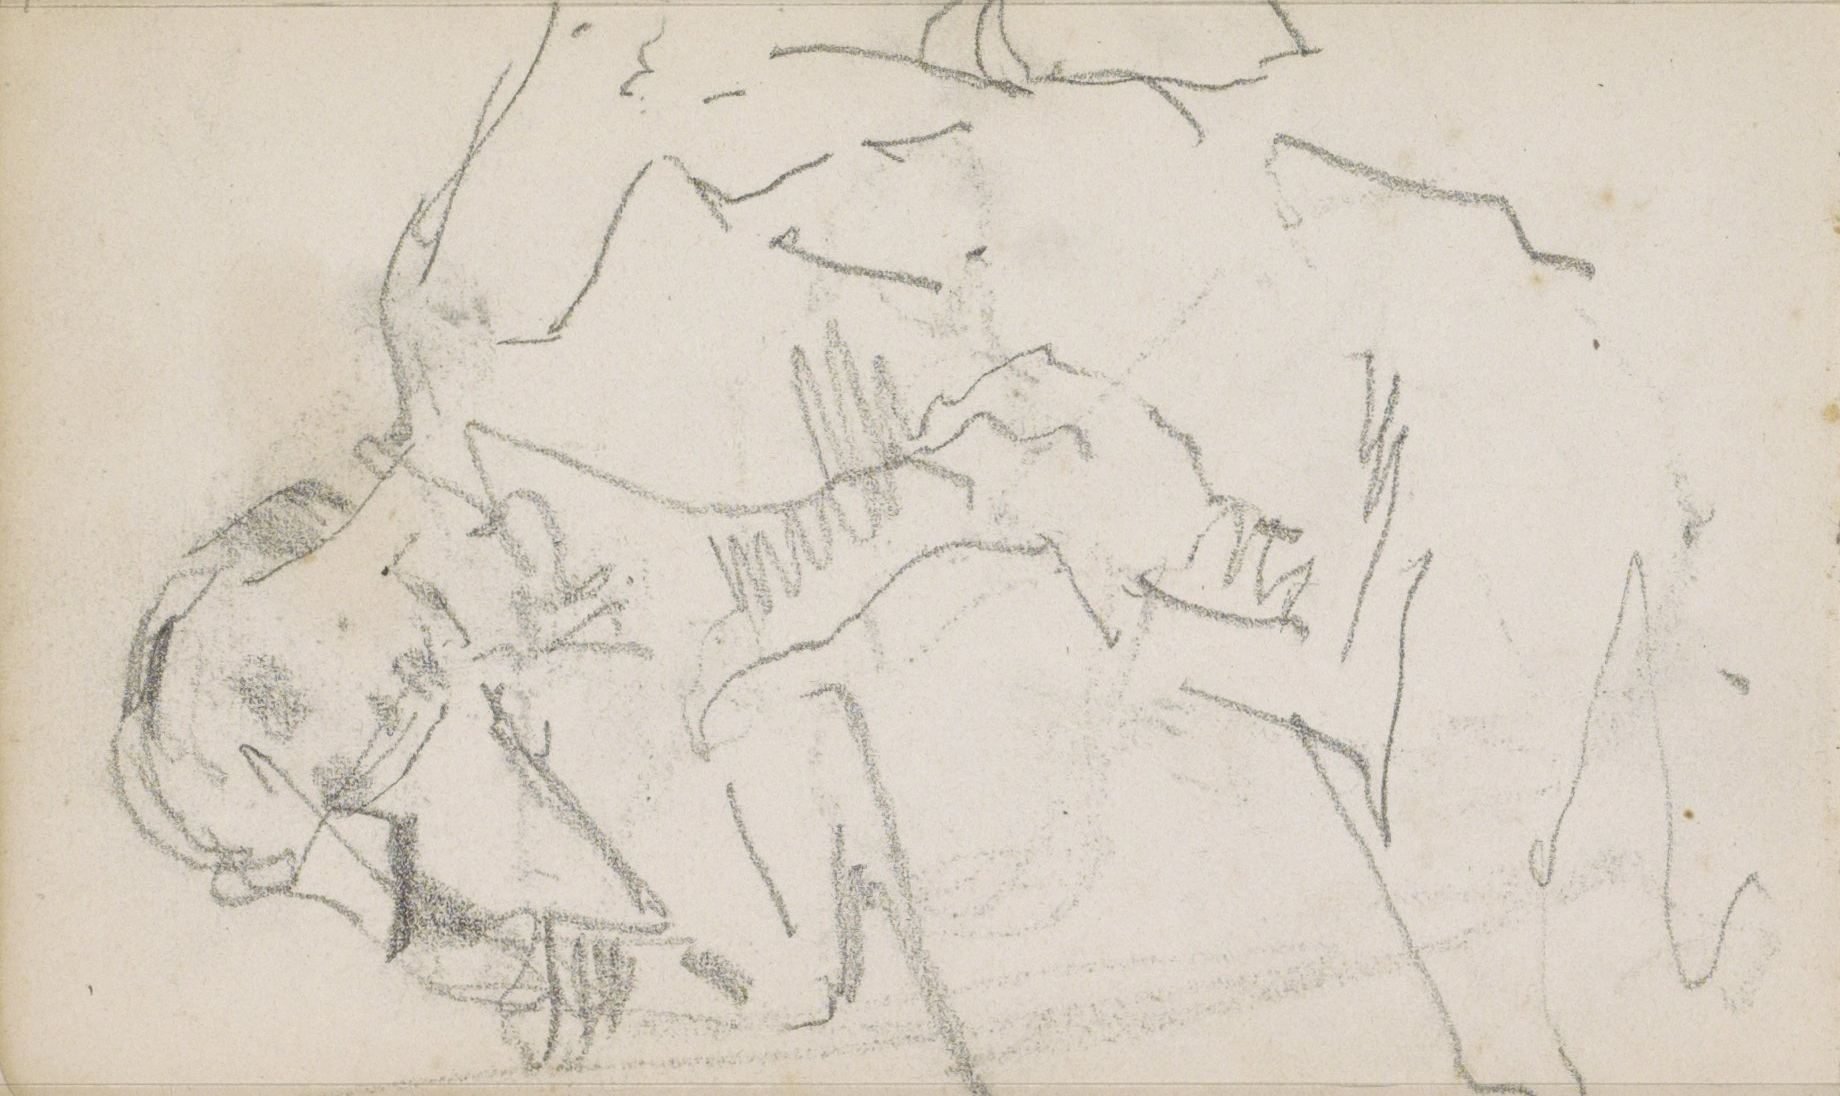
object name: sketchbook leaf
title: Zittende vrouw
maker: george hendrik breitner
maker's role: draughtsman, painter, print maker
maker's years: 1857-1923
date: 1881-1883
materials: paper, pencil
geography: north brabant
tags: adult woman, sitting figure - aa - female human figure, head held in the hand(s), with elbows leaning on an elevation or on the knees (+ female (human being) (not to be used where -aa- is prescribed))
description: Ze ondersteunt haar hoofd met haar rechterhand. Pagina 71 uit een schetsboek met 42 bladen.